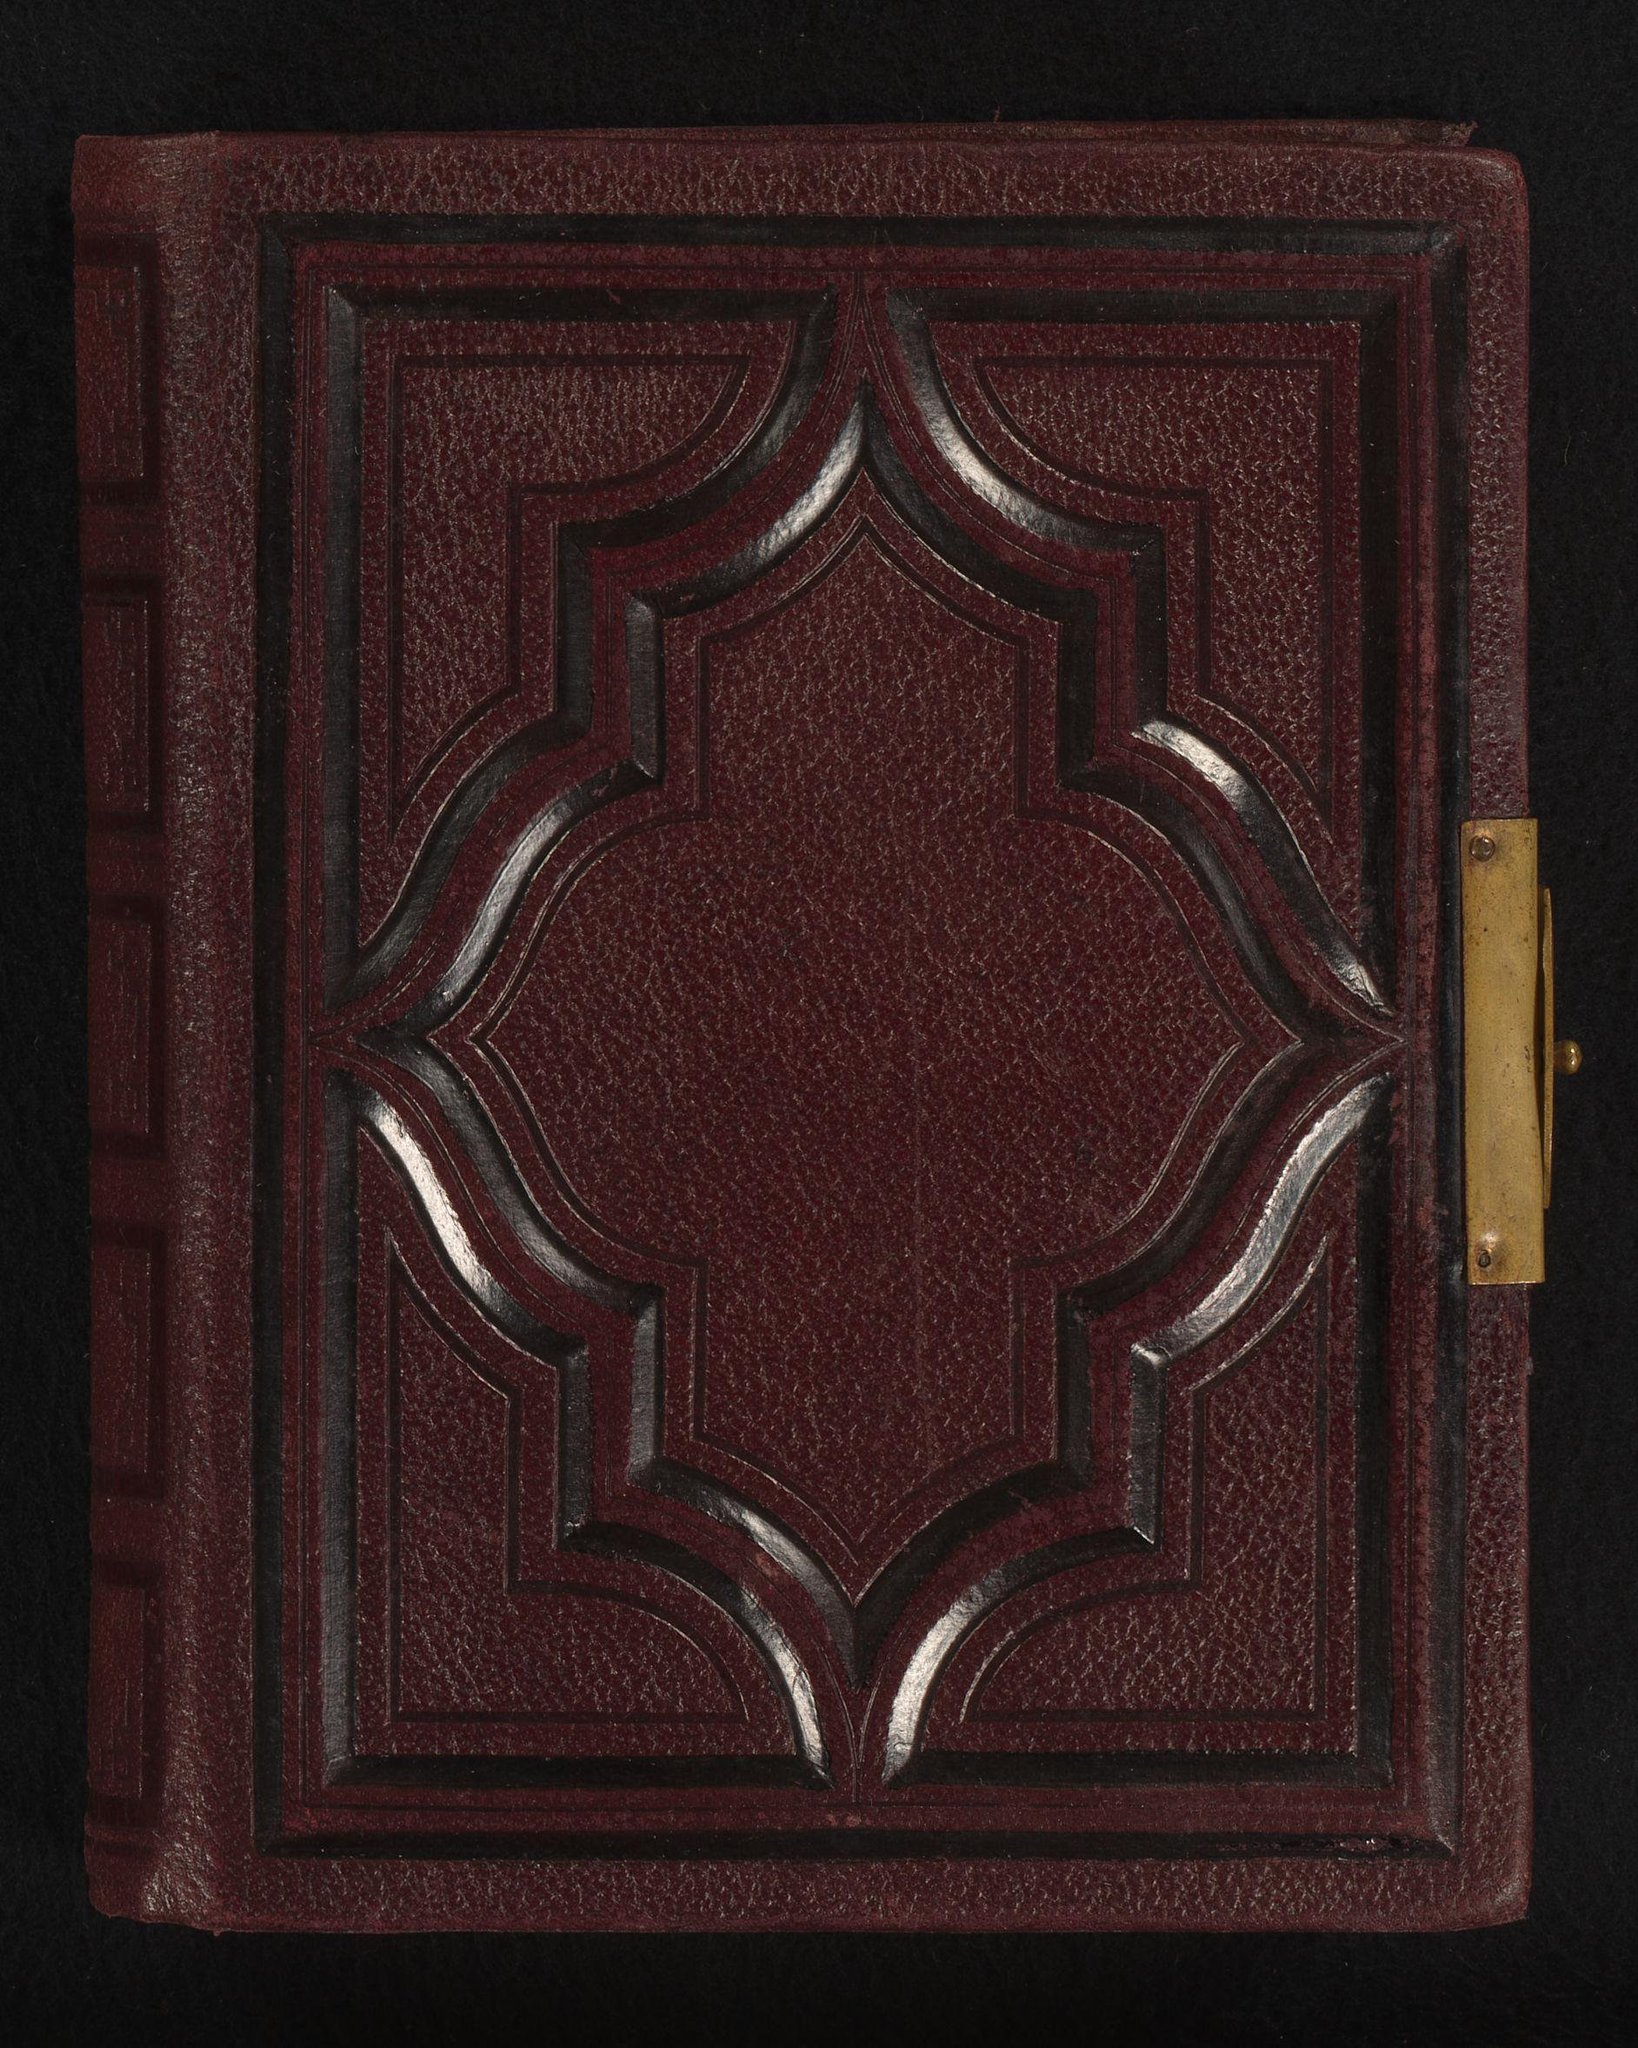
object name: slip in album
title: Fotoalbum (leeg)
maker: Anonymous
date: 1860-1900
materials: cardboard, leather, metal, paper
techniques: color on snow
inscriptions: collector's mark: ‘DIENST/ VERSPREIDE/ RIJKSKOLLEKTIES/ (...) A 748’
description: Fotoalbum met 48 pagina's met ieder een met gepreegde rand omkaderde passe-partout voor een carte-de-visite.